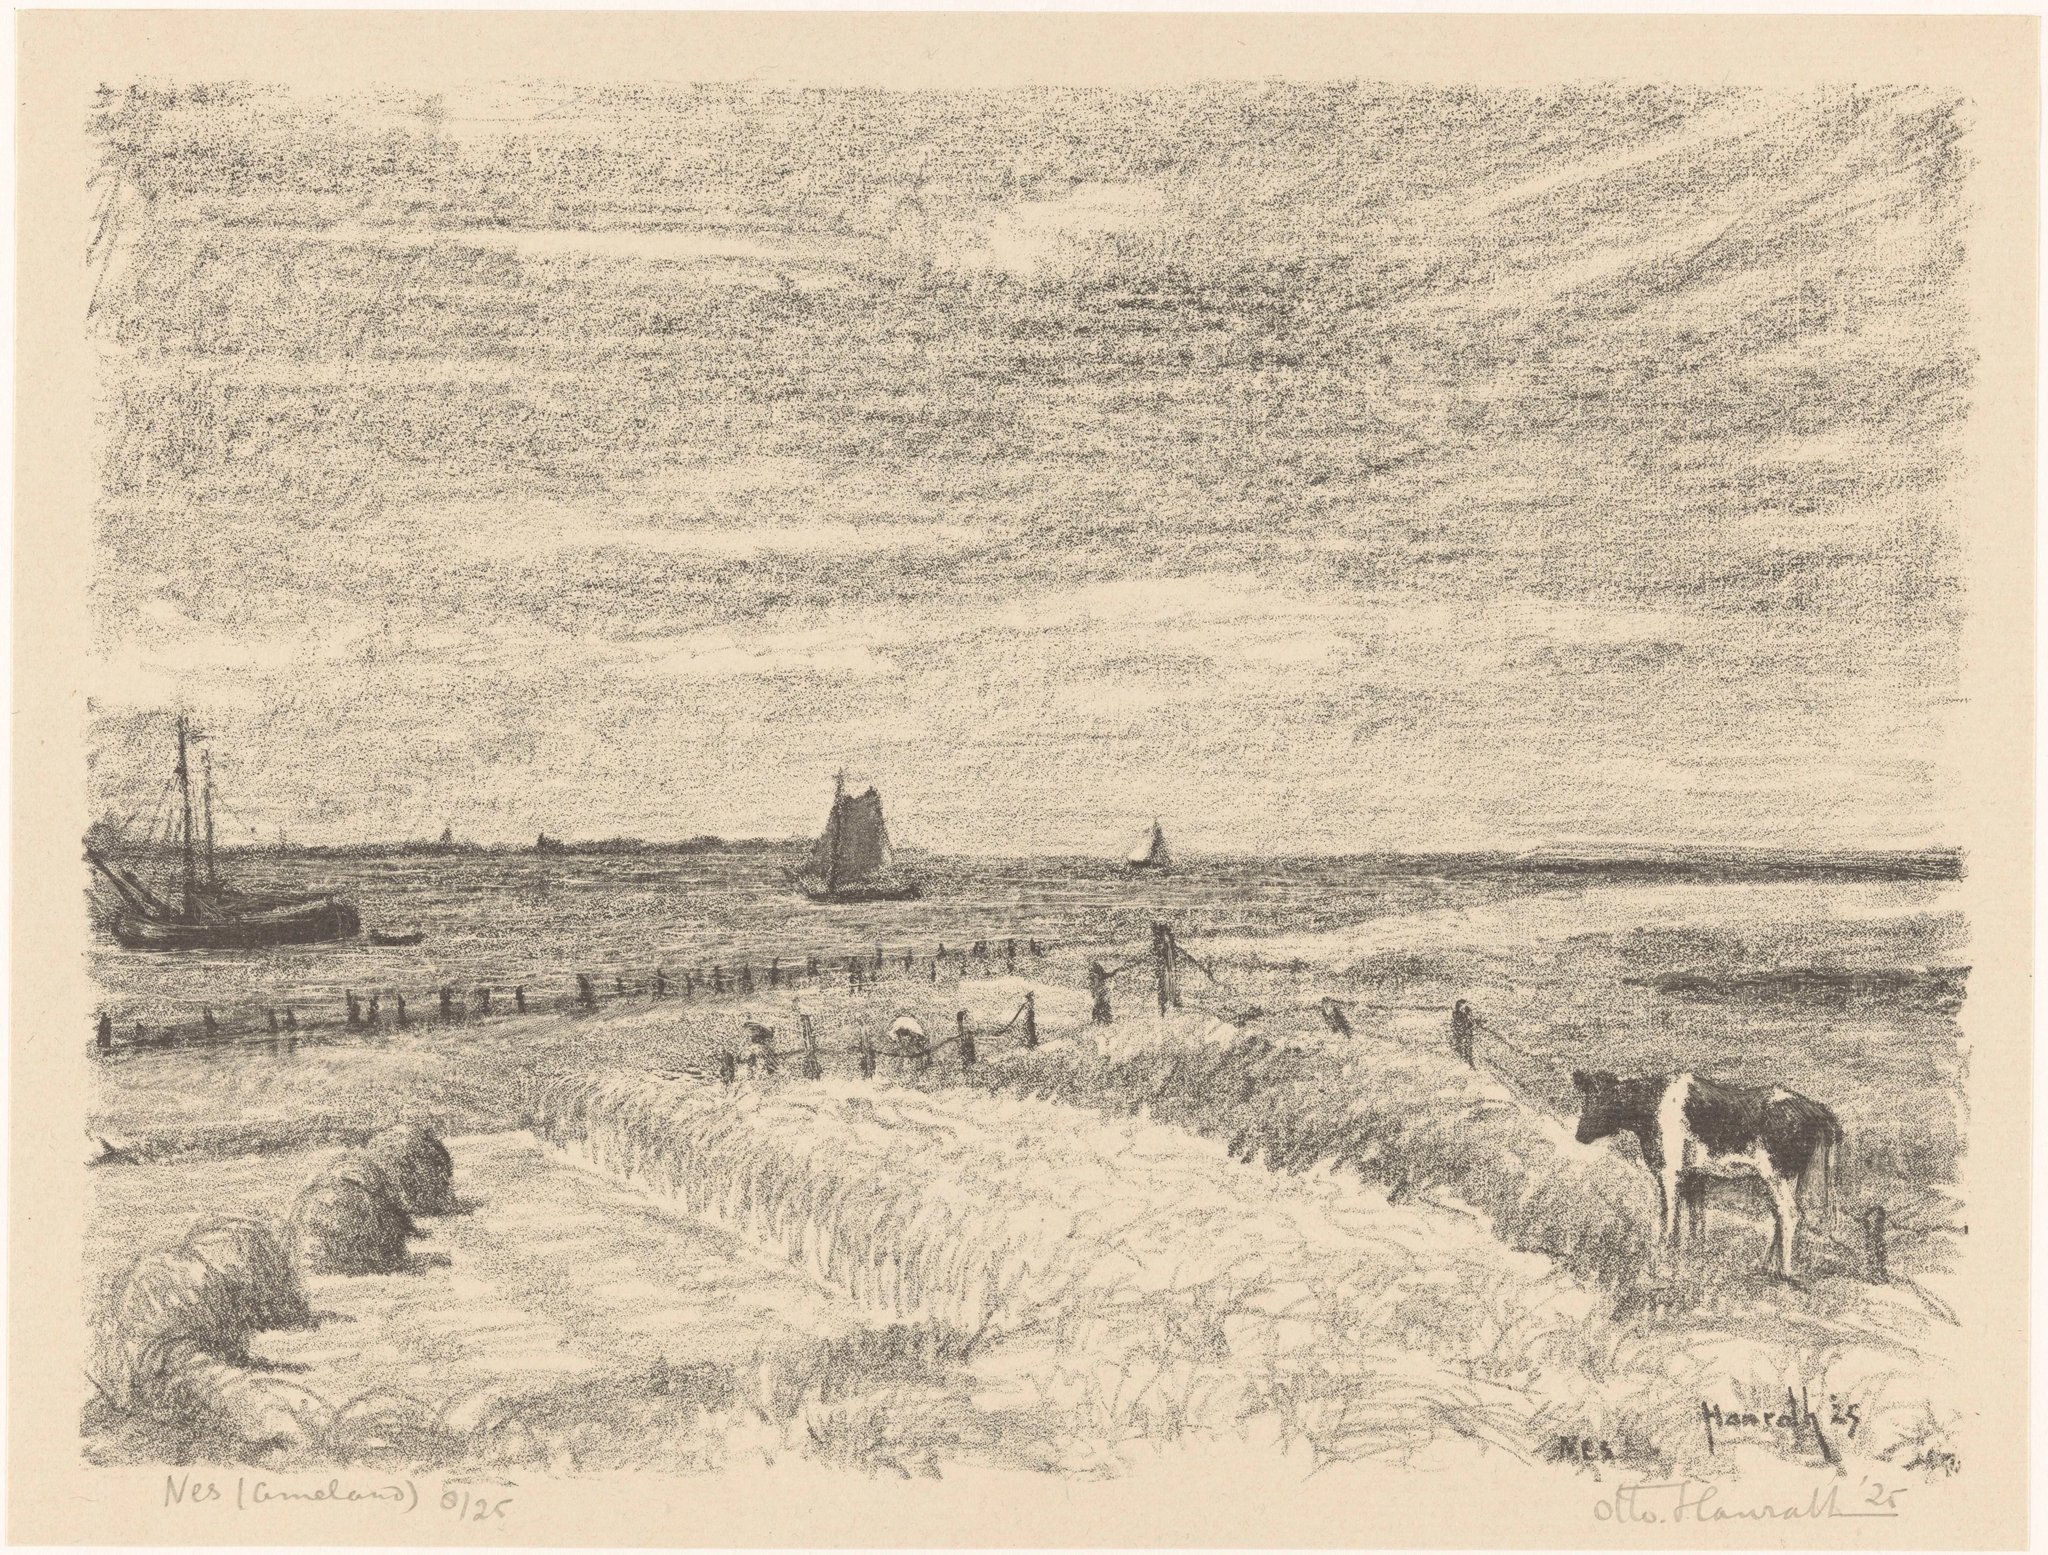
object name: print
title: Nes (Ameland)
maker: otto hanrath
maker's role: print maker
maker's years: 1882-1944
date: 1925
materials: paper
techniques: lithograph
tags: sailing-ship, sailing-boat, meadow, pasture, calf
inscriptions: collector's mark: Lugt 2228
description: Op de voorgrond een kalf in een weiland. Op de achtergrond zeilschepen op de Waddenzee.